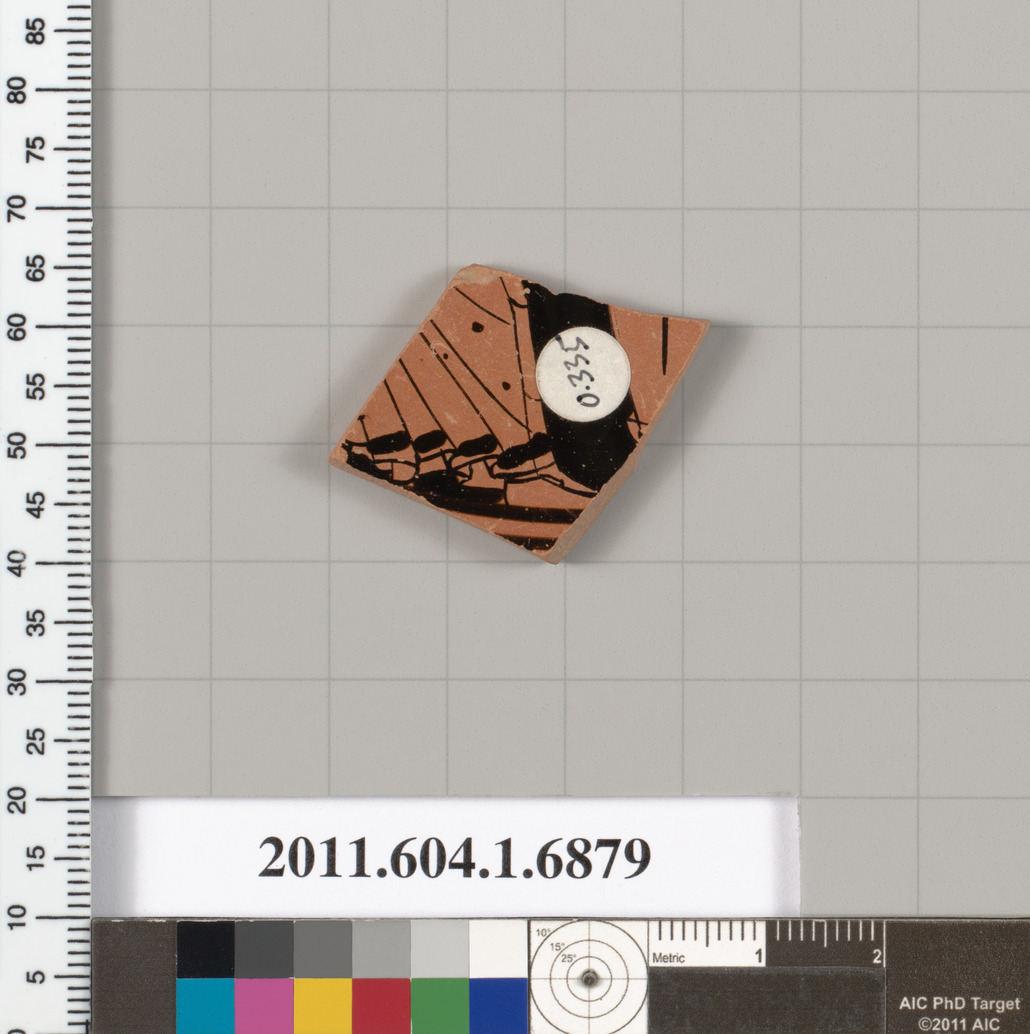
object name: kylix fragment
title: Terracotta fragment of a kylix (drinking cup)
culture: greek, attic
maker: brygan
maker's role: artist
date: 490-470 BCE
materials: terracotta